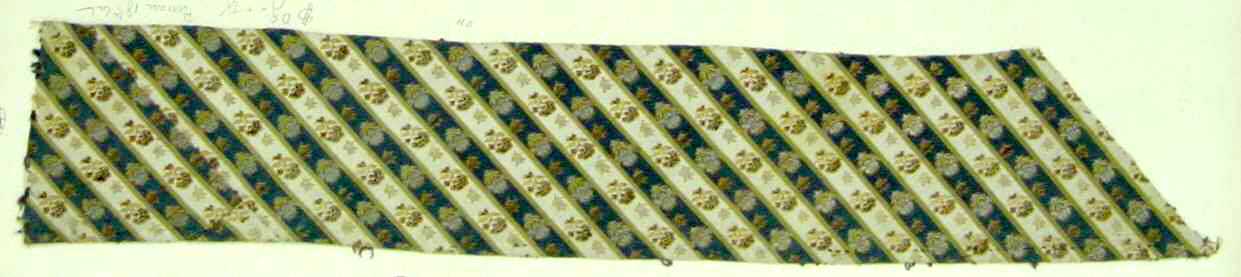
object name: textile fragment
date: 1701-1800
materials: silk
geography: iran